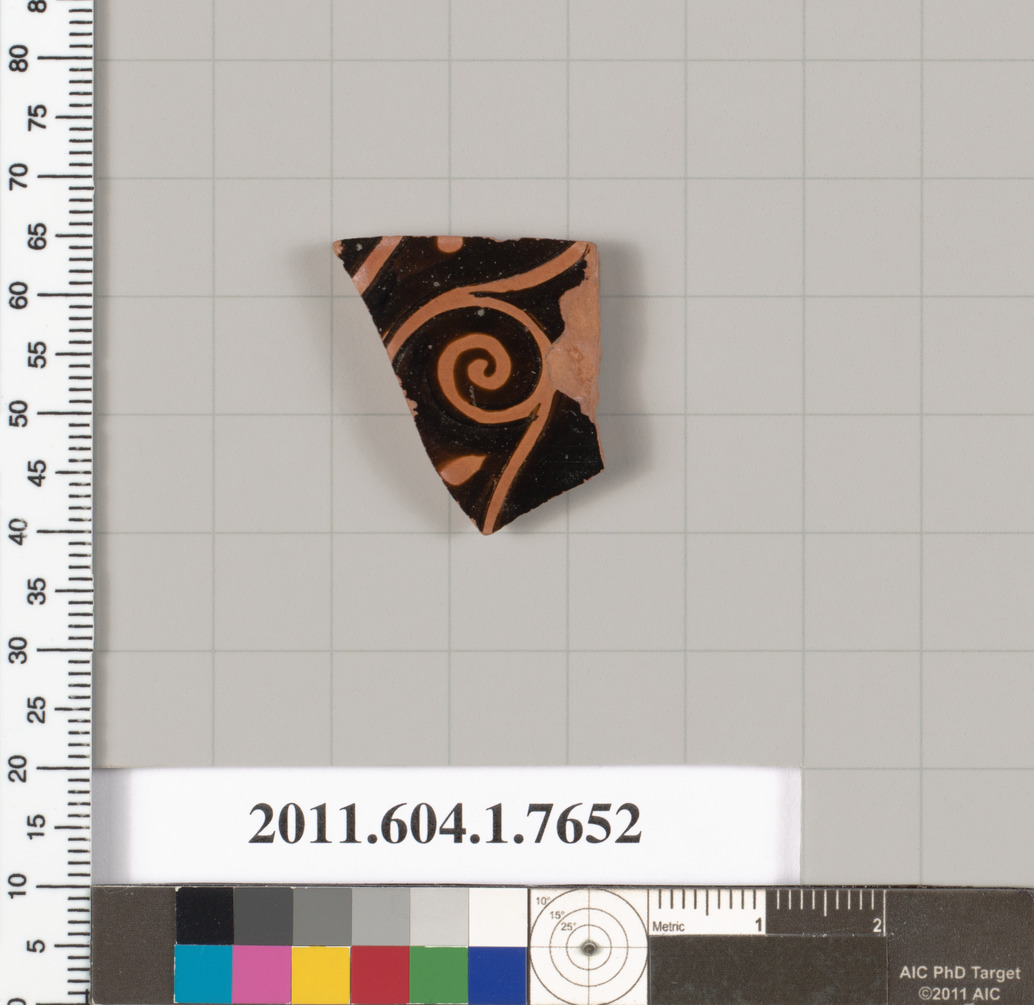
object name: kylix fragment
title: Terracotta fragment of a kylix (drinking cup)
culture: greek, attic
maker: euaion painter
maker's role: artist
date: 460-450 BCE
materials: terracotta